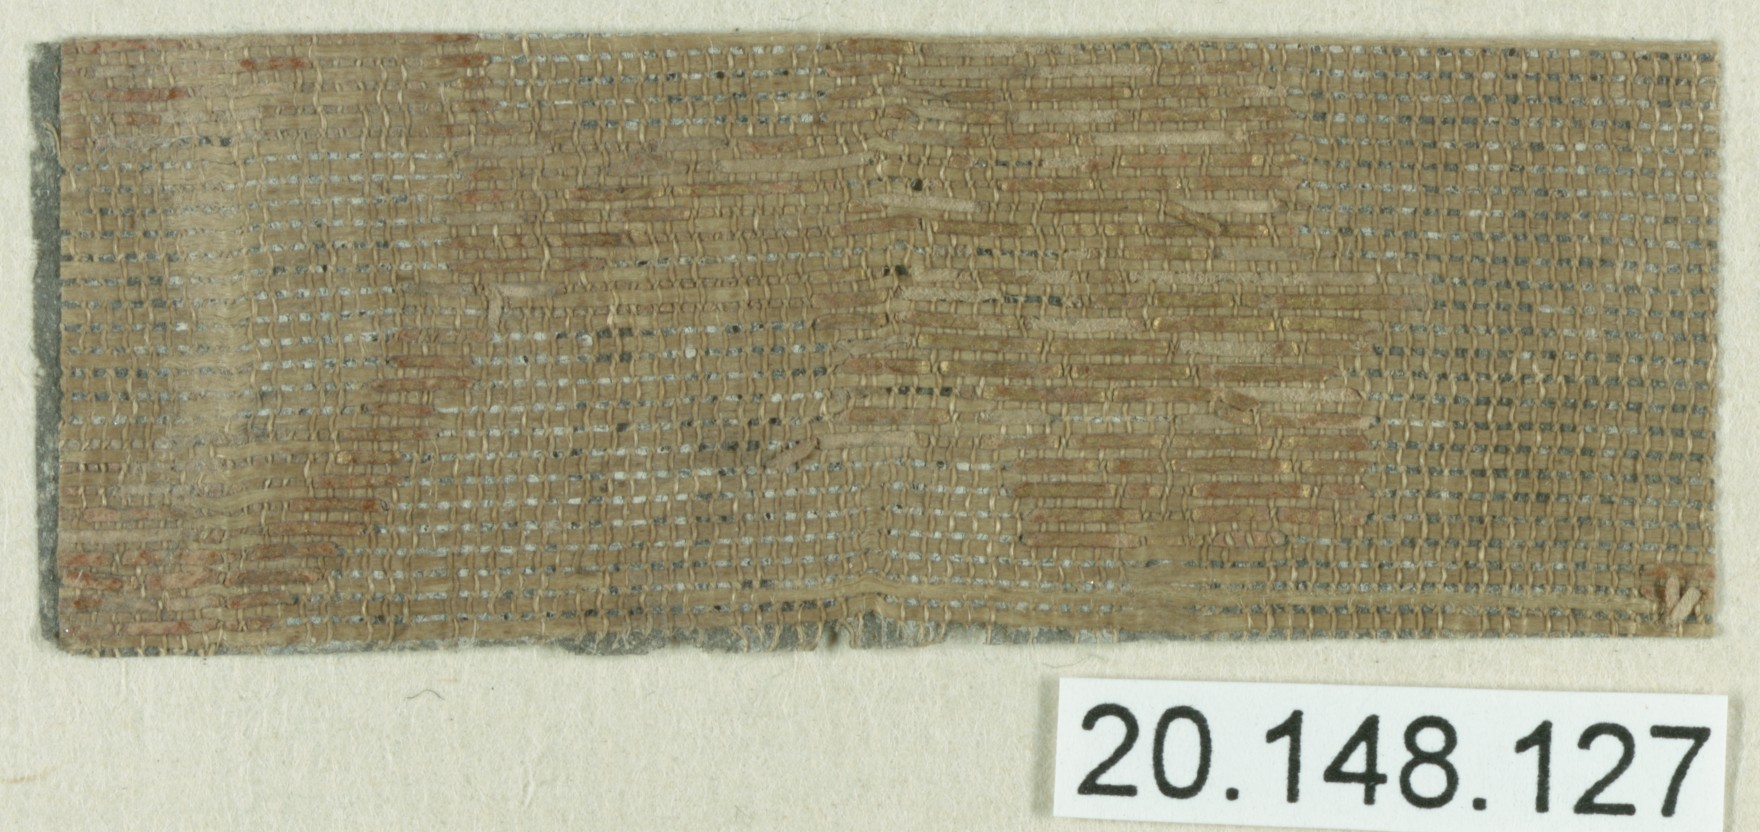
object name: textile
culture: chinese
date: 1501-1600